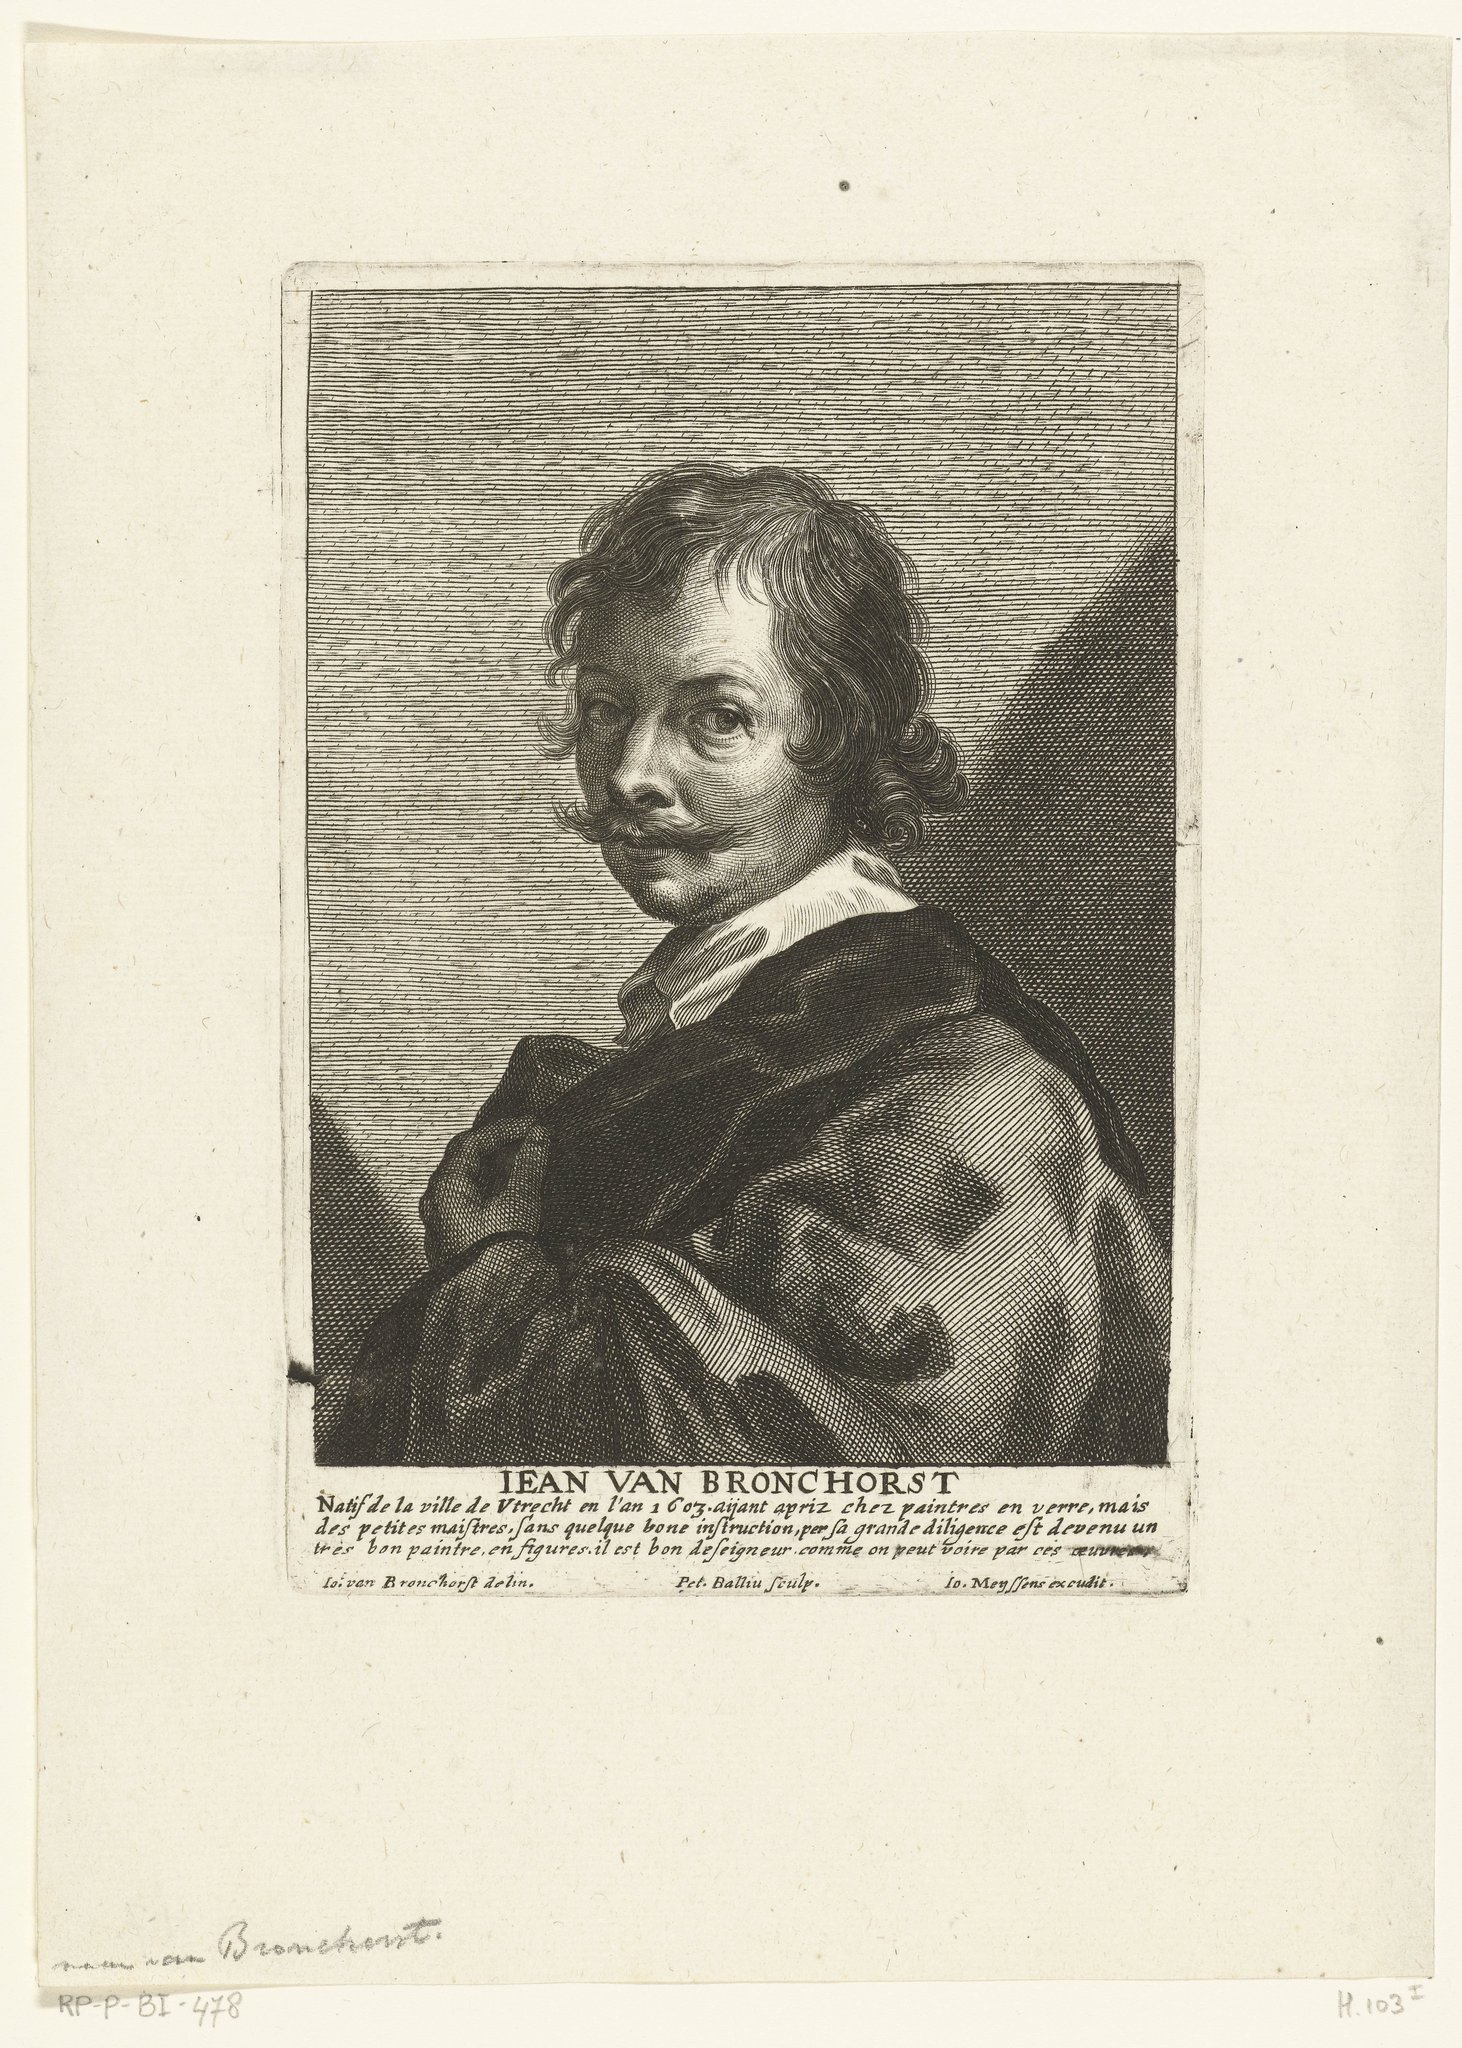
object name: print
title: Portret van kunstenaar Jan van Bronchorst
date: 1623-1660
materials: paper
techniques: engraving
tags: utrecht, amsterdam, painter, print maker, draughtsman, jan gerritsz. van bronckhorst, portrait, self-portrait of artist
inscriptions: collector's mark: Lugt 2228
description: Prent gebruikt voor: Het gulden cabinet der edel vrij schilderkonst, Cornelis de Bie (auteur), Joannes Meyssens (uitgever), Antwerpen 1661